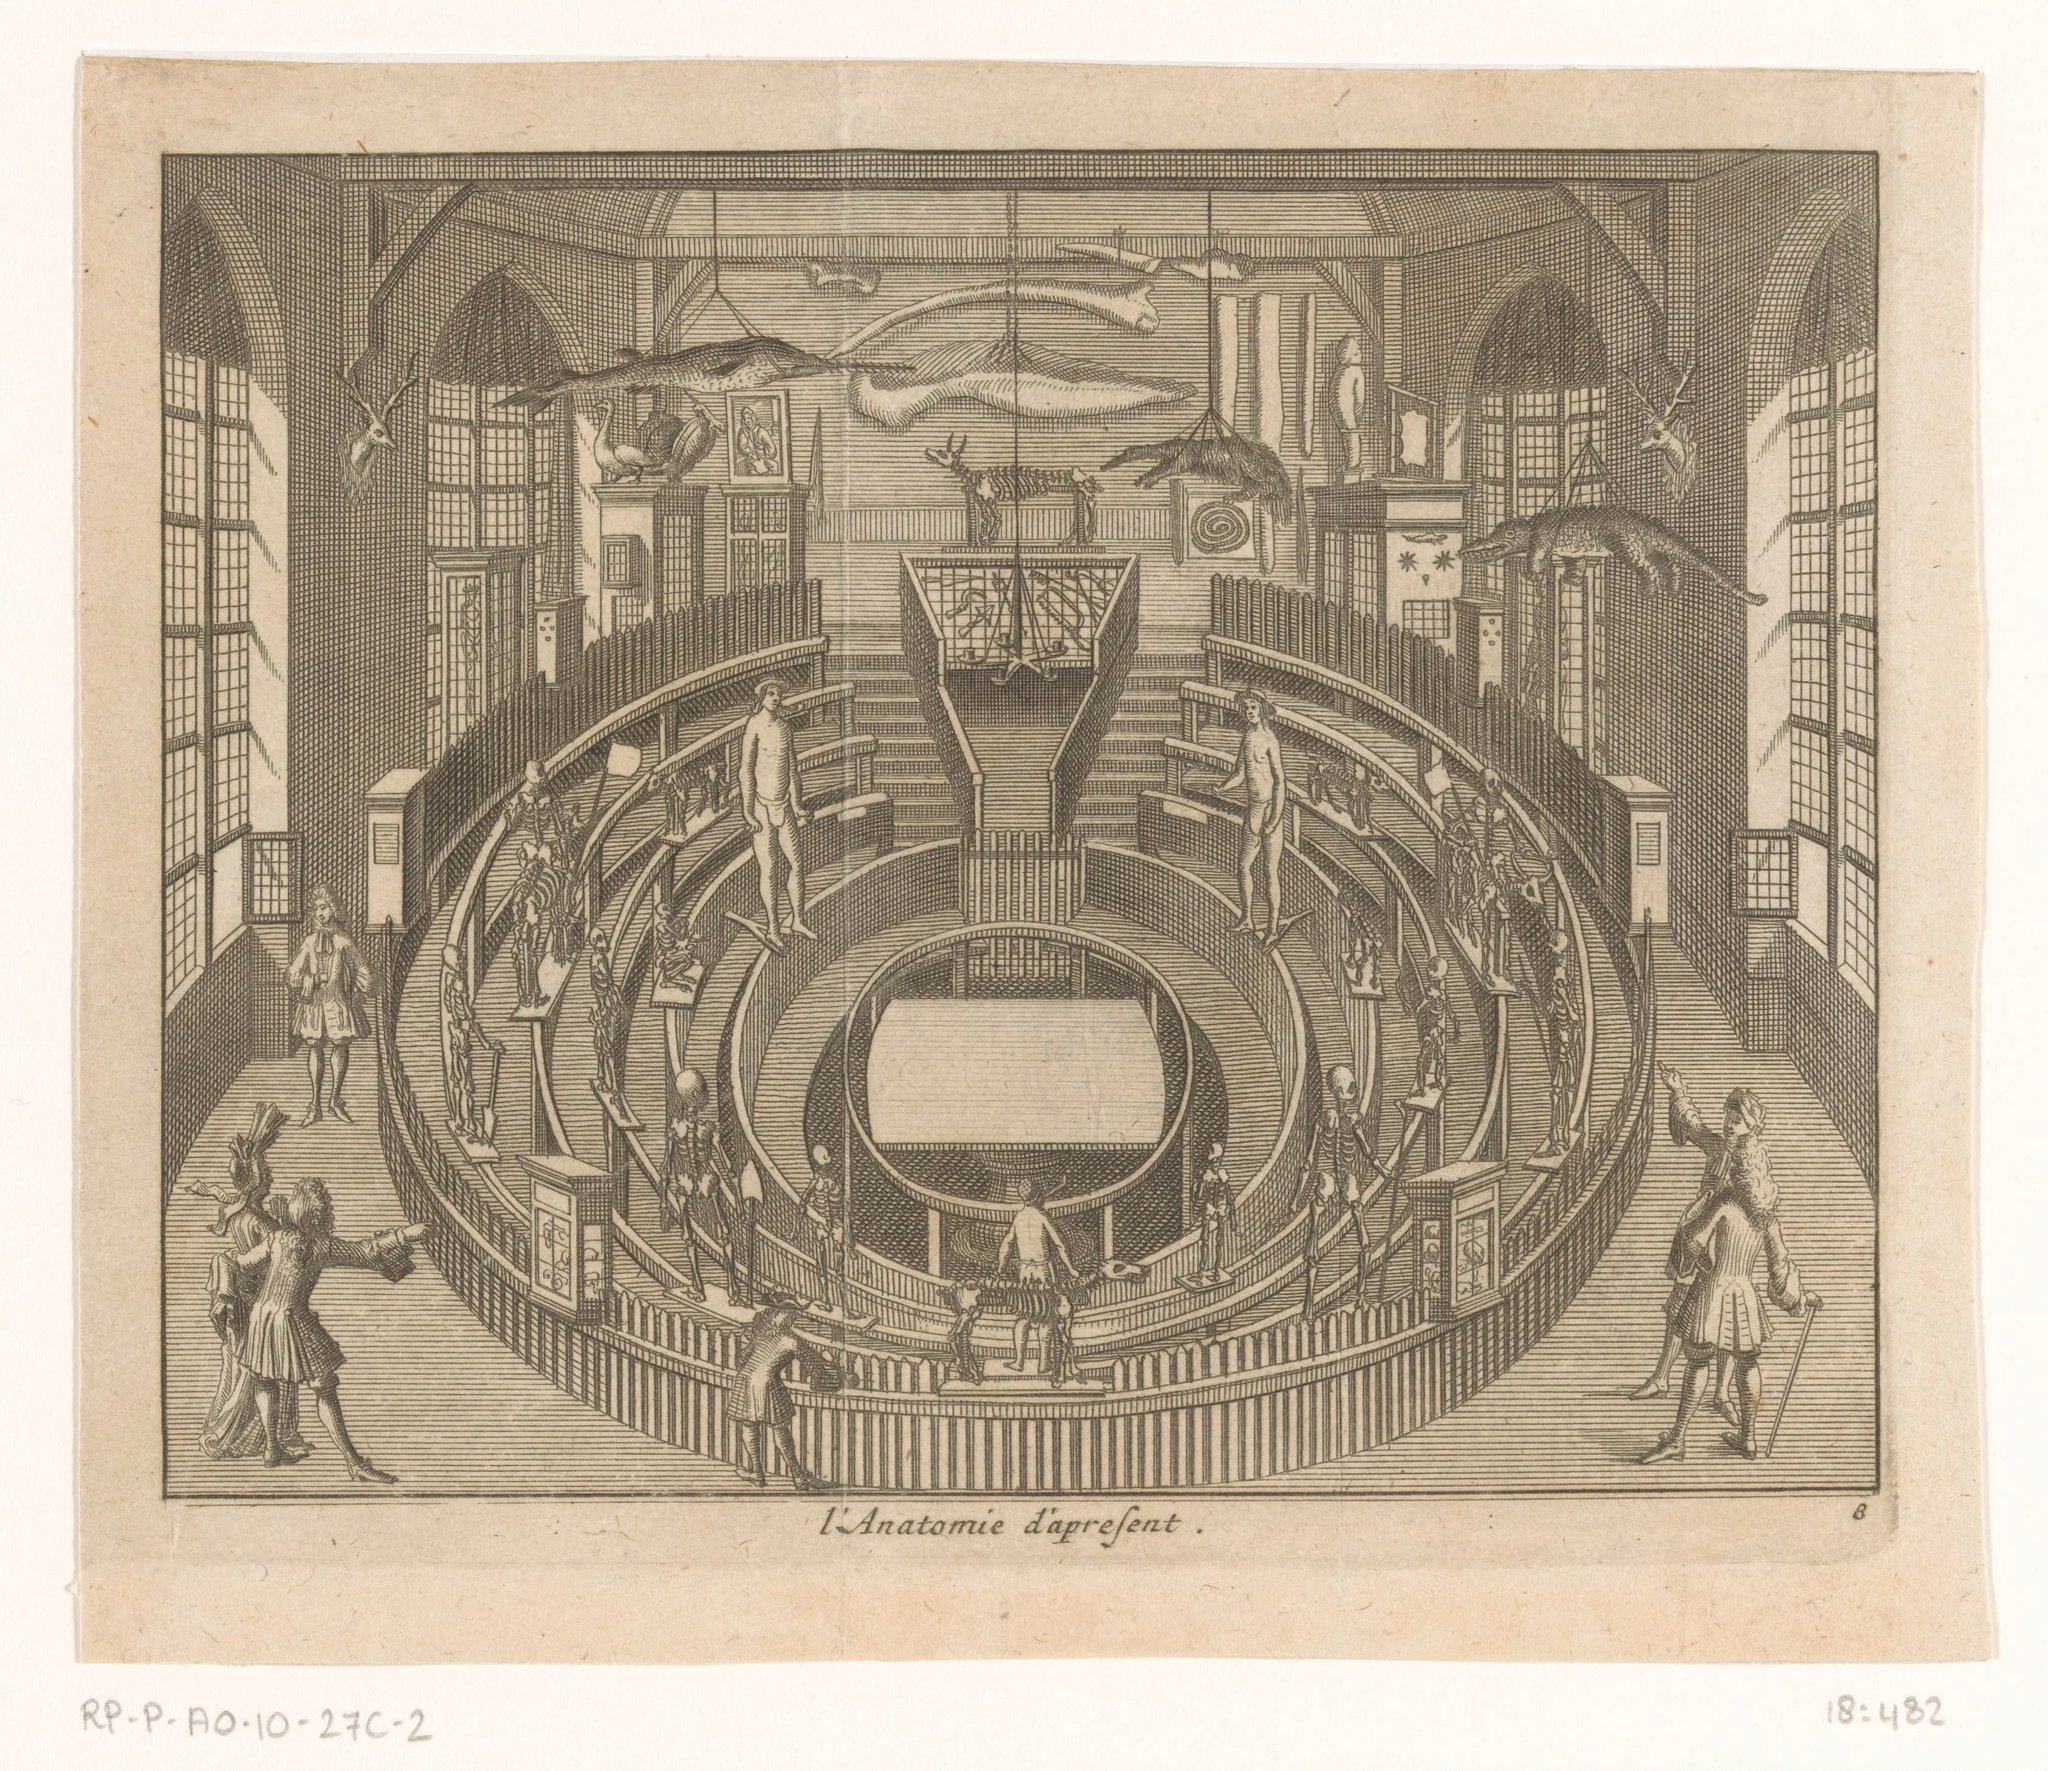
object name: print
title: L'Anatomie d'apresent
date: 1712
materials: paper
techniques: etching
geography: leiden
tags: dissecting-room, 'theatrum anatomicum', university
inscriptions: collector's mark: Lugt 2228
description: Het Theatrum Anatomicum (anatomisch theater) te Leiden van binnen gezien, zoals het er ten tijde van het verschijnen van deze prent uitzag (1712). In de ruimte zijn verschillende mensen aanwezig en staan skeletten van mensen en dieren opgesteld. Aan het plafond hangen opgezette dieren. Rechtsonder genummerd: 8.